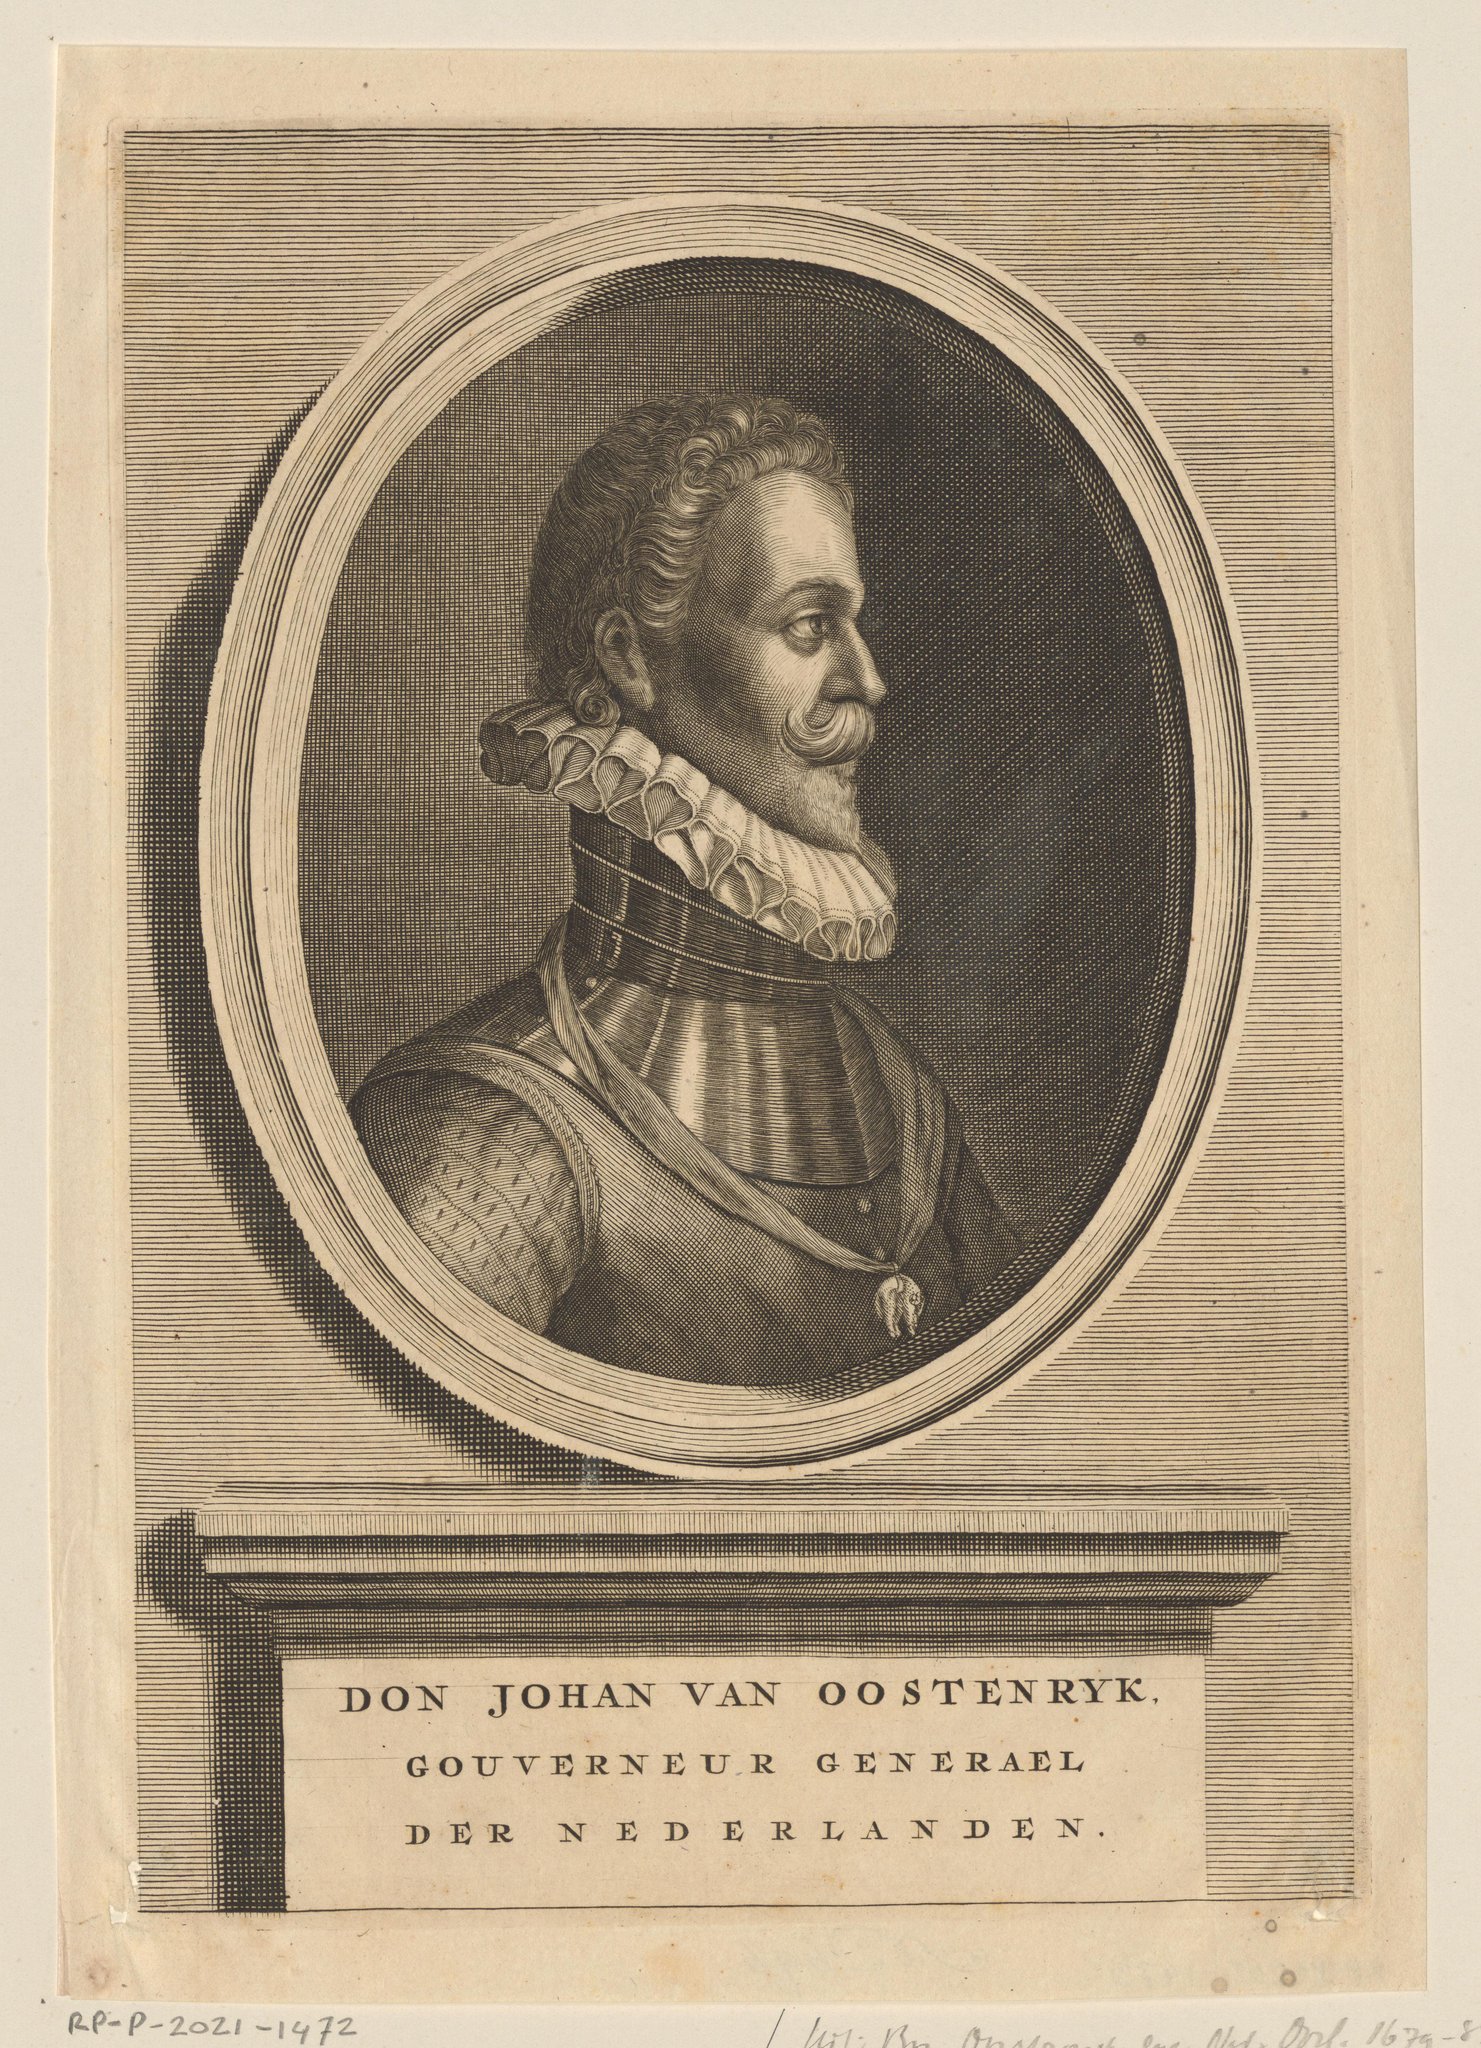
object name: print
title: Portret van Don Juan van Oostenrijk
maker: Anonymous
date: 1679-1703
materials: paper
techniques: engraving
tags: don juan van oostenrijk, historical persons, knighthood order of the golden fleece, ruler, sovereign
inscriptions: inscription: ‘No. 696’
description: Prent mogelijk uit: Bor, Pieter Christiaensz. Oorsprongk, begin en vervolgh der Nederlandsche oorlogen (...). Amsterdam: weduwe Joannes van Someren et al., 1679. Of mogelijk uit: Hooft, Pieter Corneliszoon. Nederlandsche historien, seedert de ooverdraght der heerschappye van kaizar Karel den Vyfden op koning Philips zynen zoon, tot het einde der landtvooghdye des graven van Leicester. Amsterdam: Hendrik Wetstein en Pieter Sceperus en Leiden: Daniel van den Dalen en Utrecht: Willem van de Water, 1703, dl. 1. Latere staat van prent gebruikt in: Le Clerc, Jean. Geschiedenissen der Vereenigde Nederlanden (...). Amsterdam: Zacharias Chatelain, 1730.